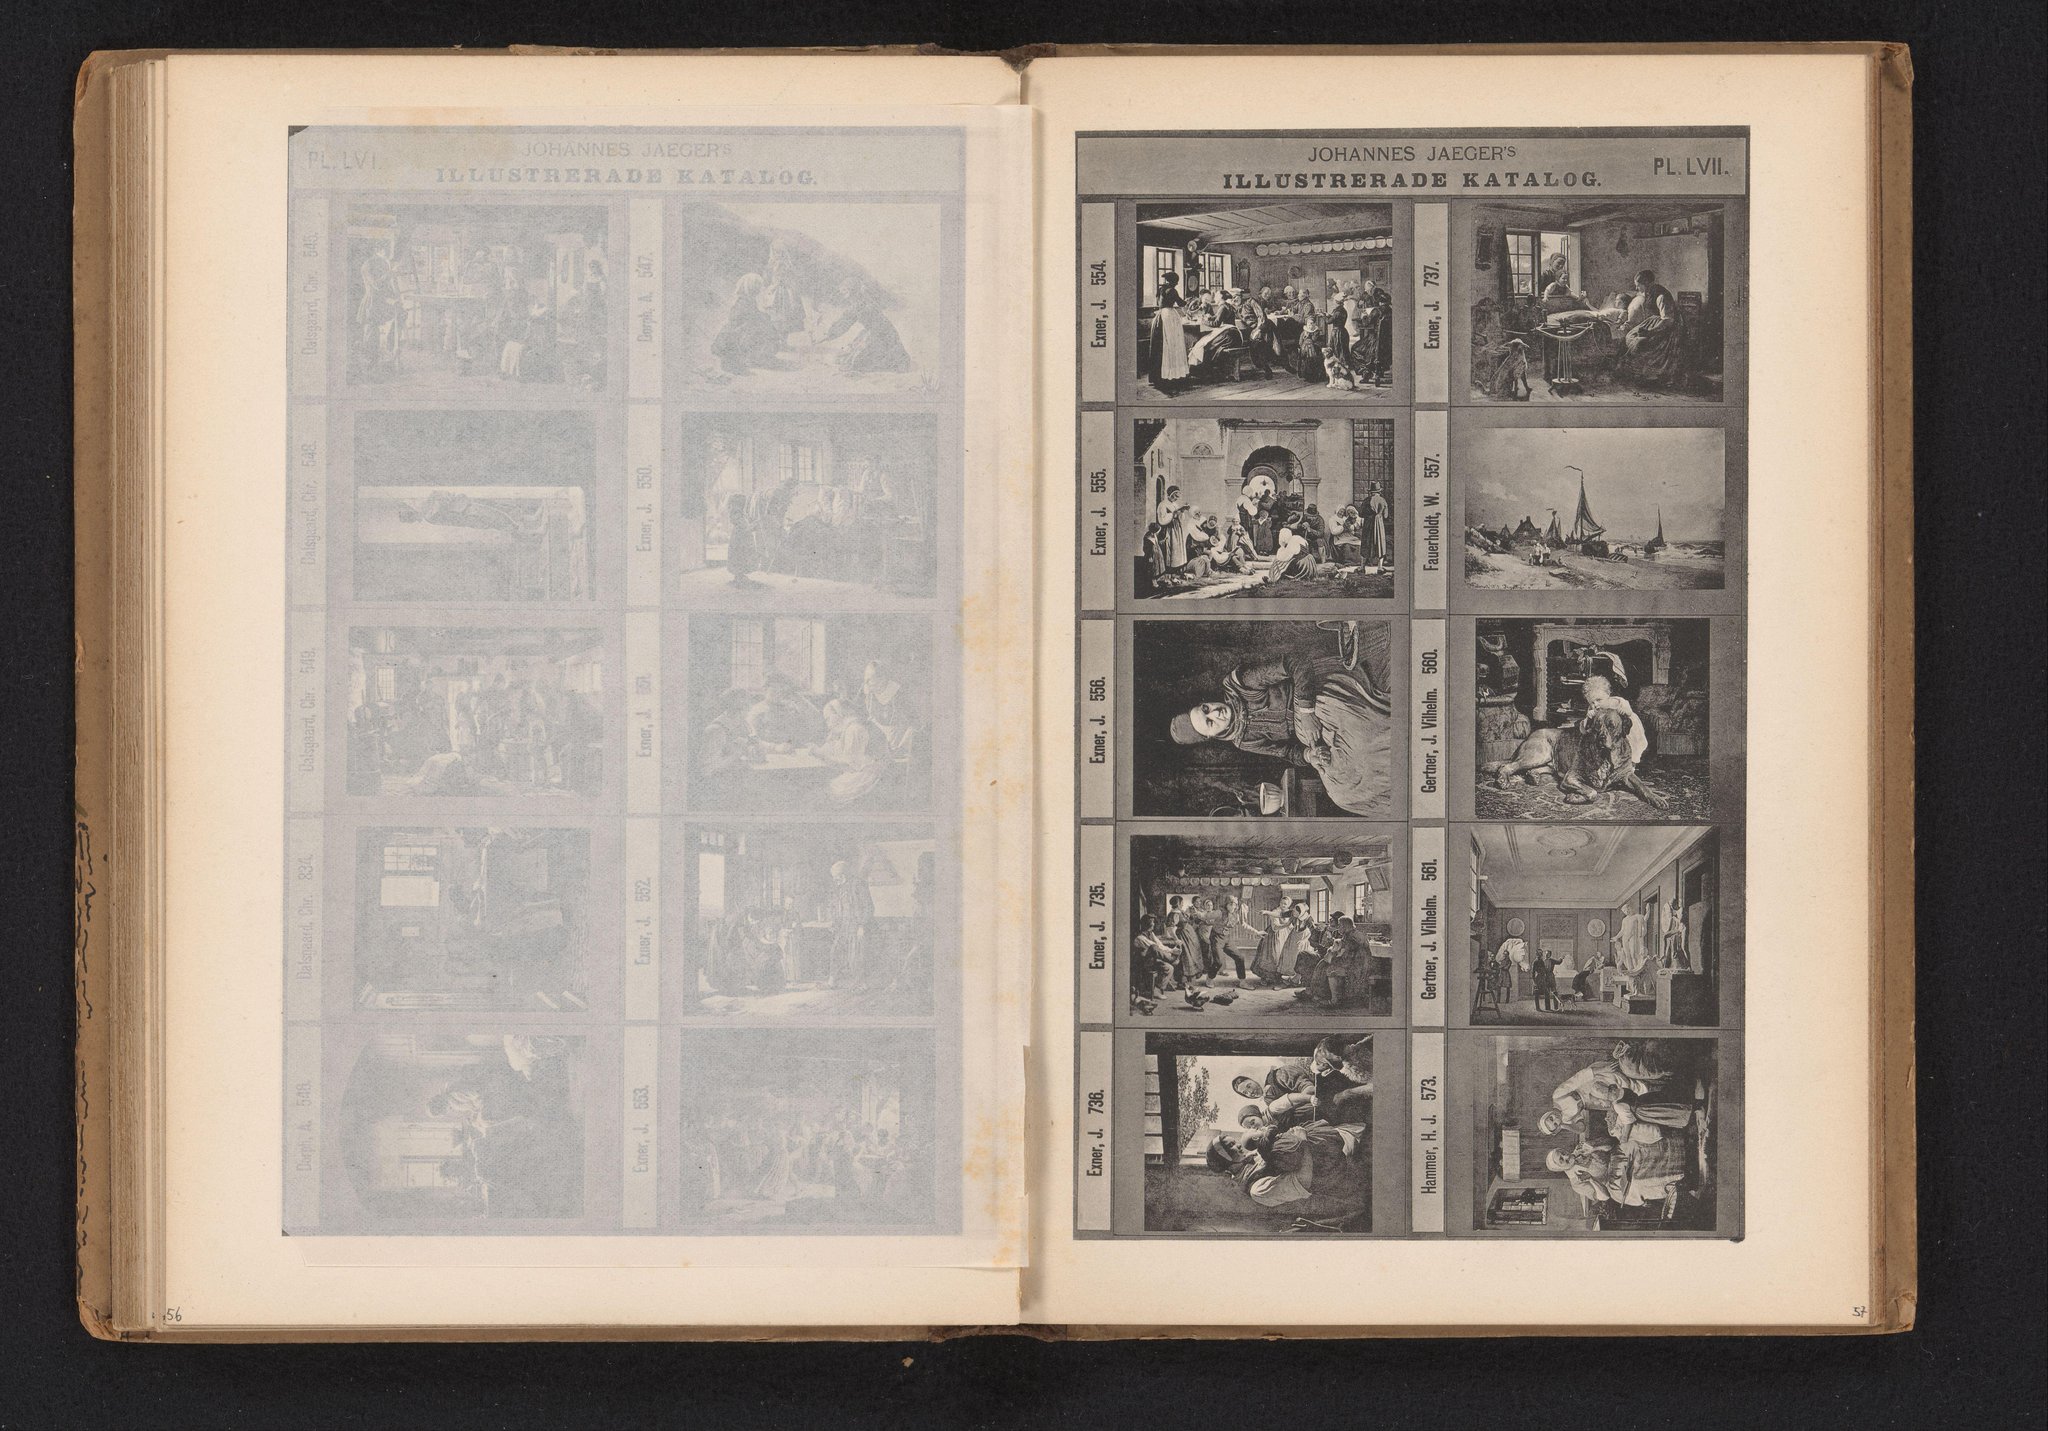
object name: photomechanical print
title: Johannes Jaeger's Illustrerade Katalog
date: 1872-1882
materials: paper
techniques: photograph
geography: stockholm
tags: picture, painting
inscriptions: number: ‘PL. LVII.’